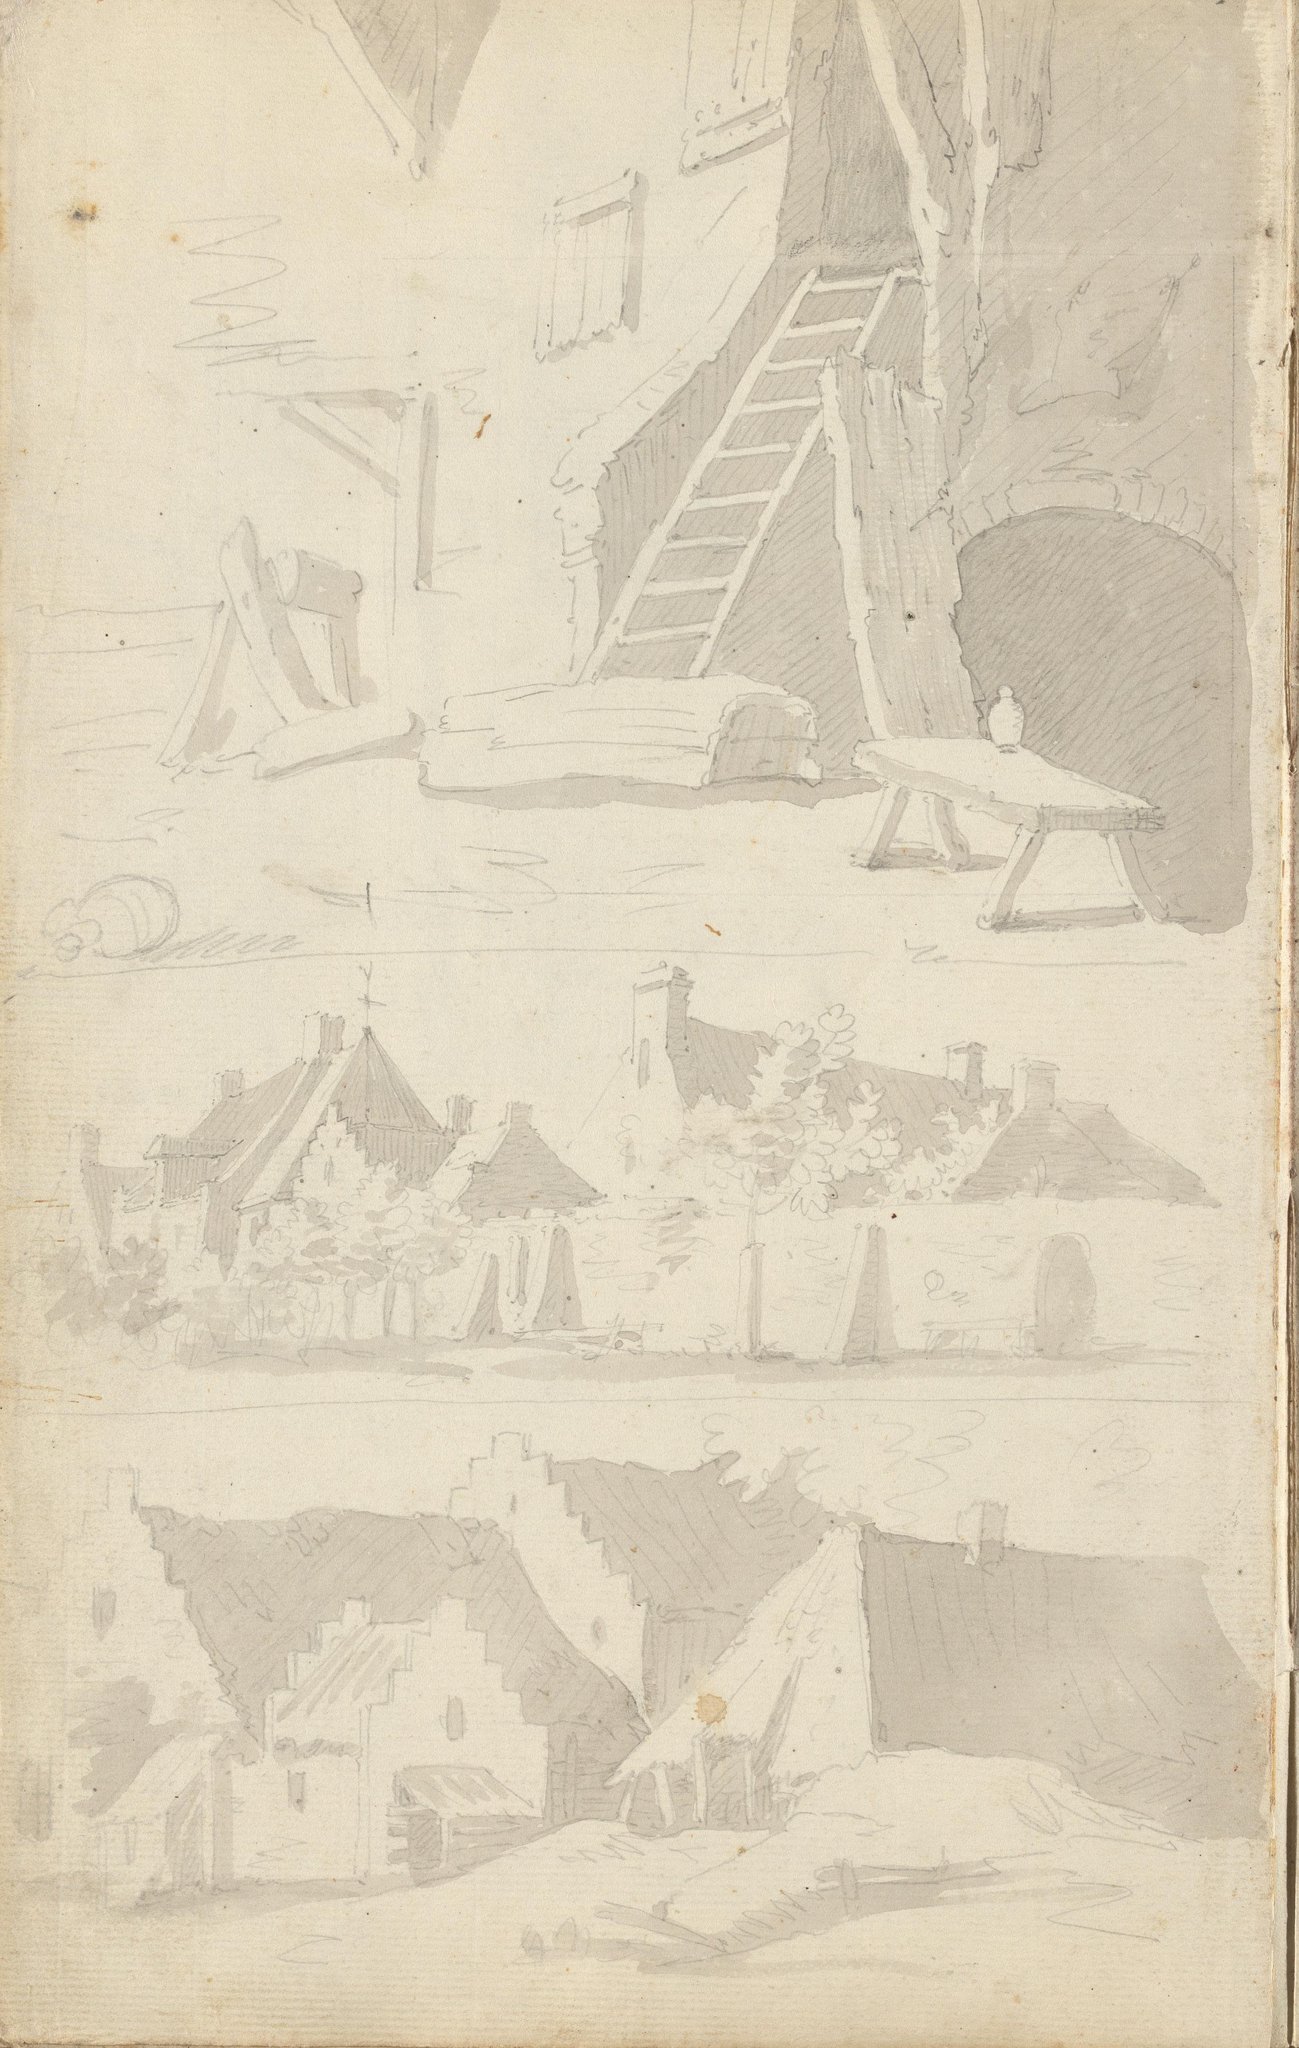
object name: sketchbook leaf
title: Boerderijen en een binnenplaats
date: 1780-1800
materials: ink, paper, pencil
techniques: brush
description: Blad 10 recto uit een schetsboek met 17 bladen.